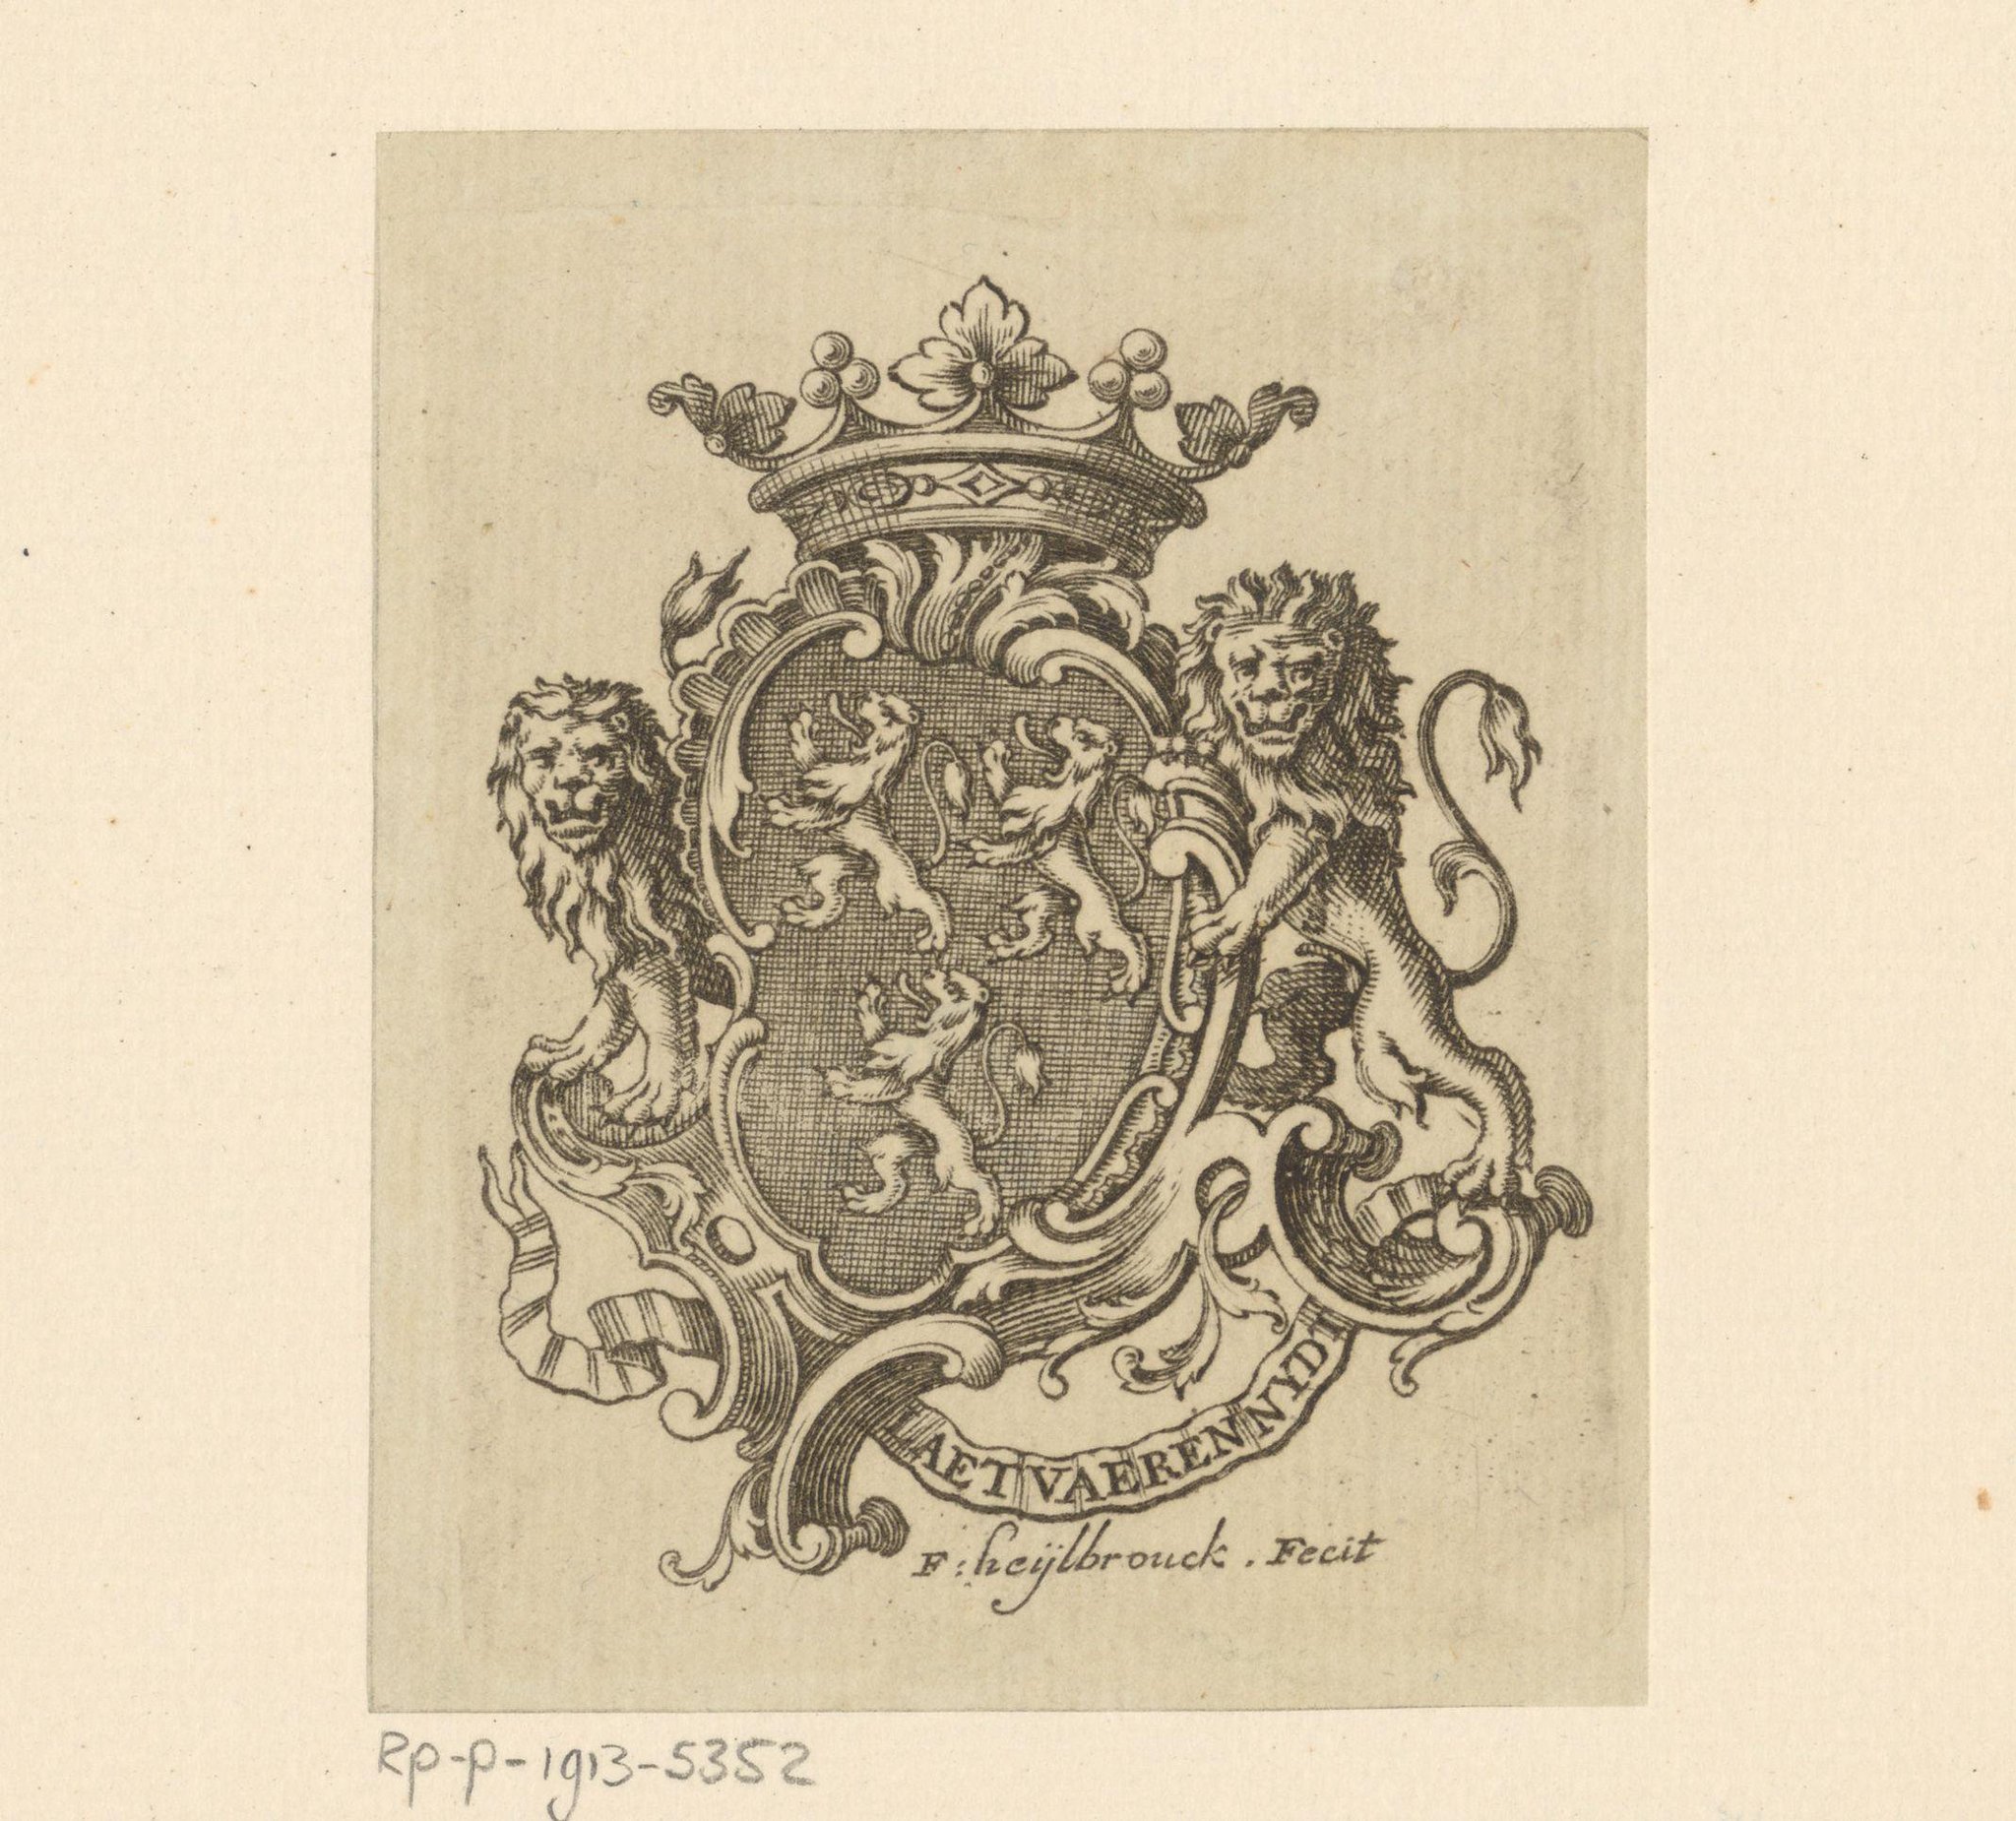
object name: bookplate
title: Laet vaeren nydt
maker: franciscus heylbrouck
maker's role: print maker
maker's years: 1704-1780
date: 1714-1780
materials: paper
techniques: engraving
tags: armorial bearing, heraldry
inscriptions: collector's mark: Lugt 2233, collector's mark: Lugt 2760